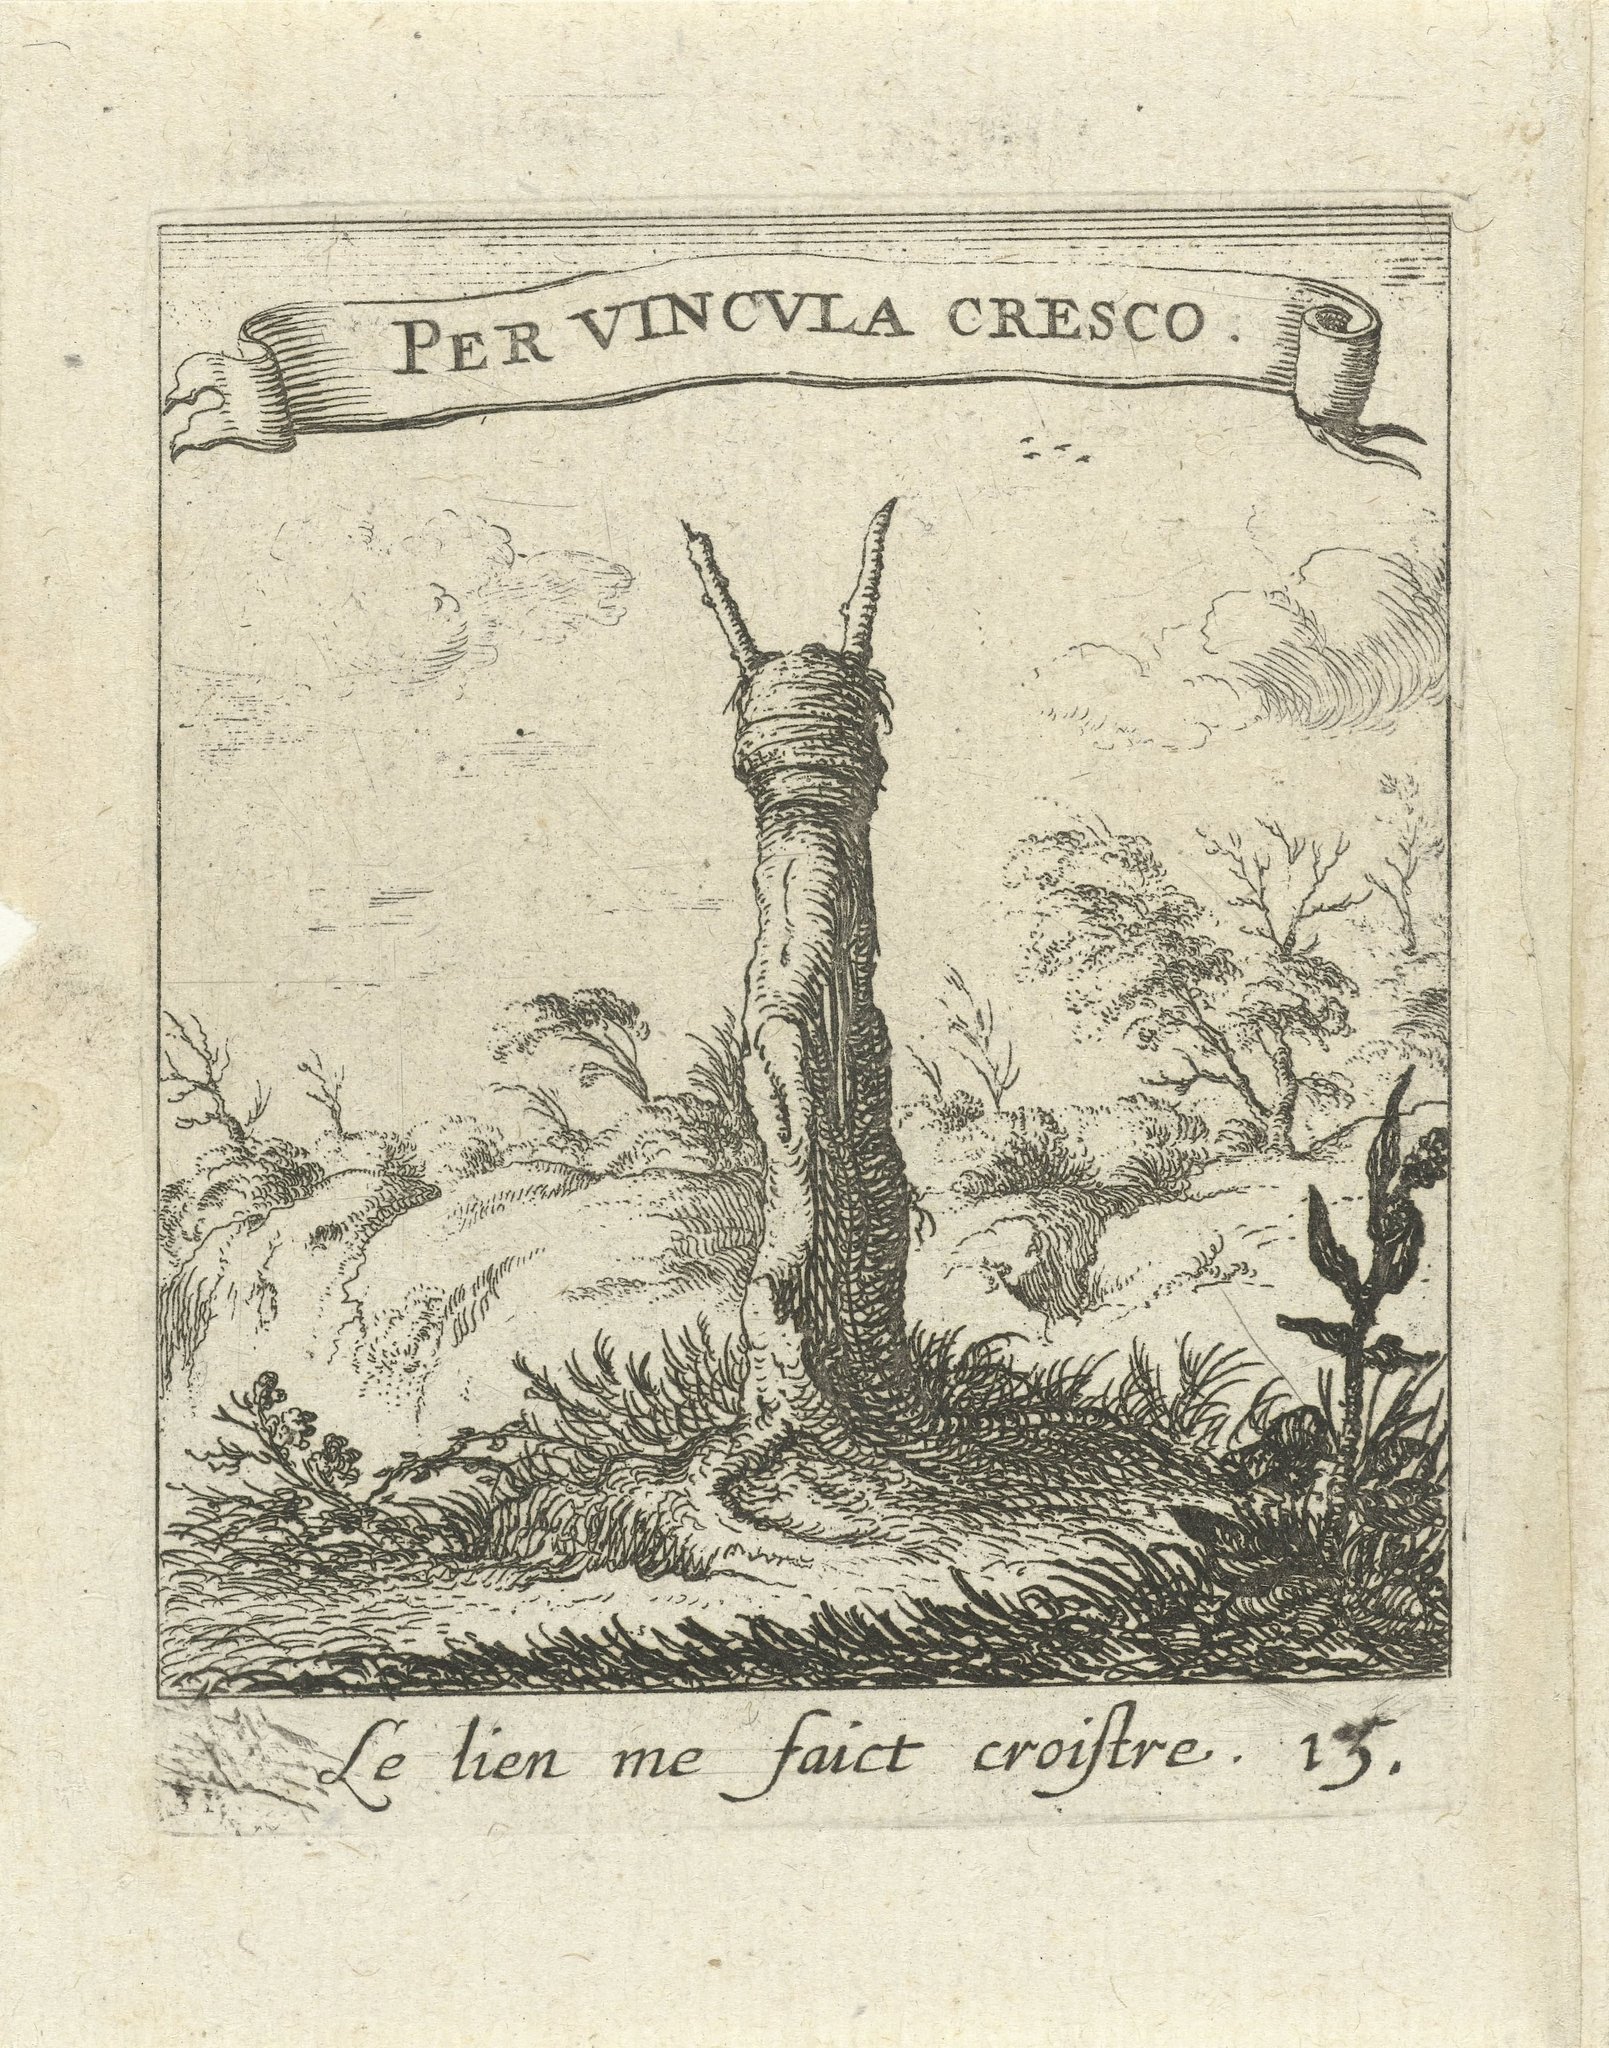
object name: print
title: Devises et emblesmes d'amovr moralisez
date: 1672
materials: paper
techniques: etching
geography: france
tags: qualities of love: first series (+ emblematical representation of concept)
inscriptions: collector's mark: Lugt 2166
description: Een landschap met een boomstam waaruit twee loten omhoog steken. Op een banderol een devies in Latijn en een onderschrift in Frans, beide over de liefde.